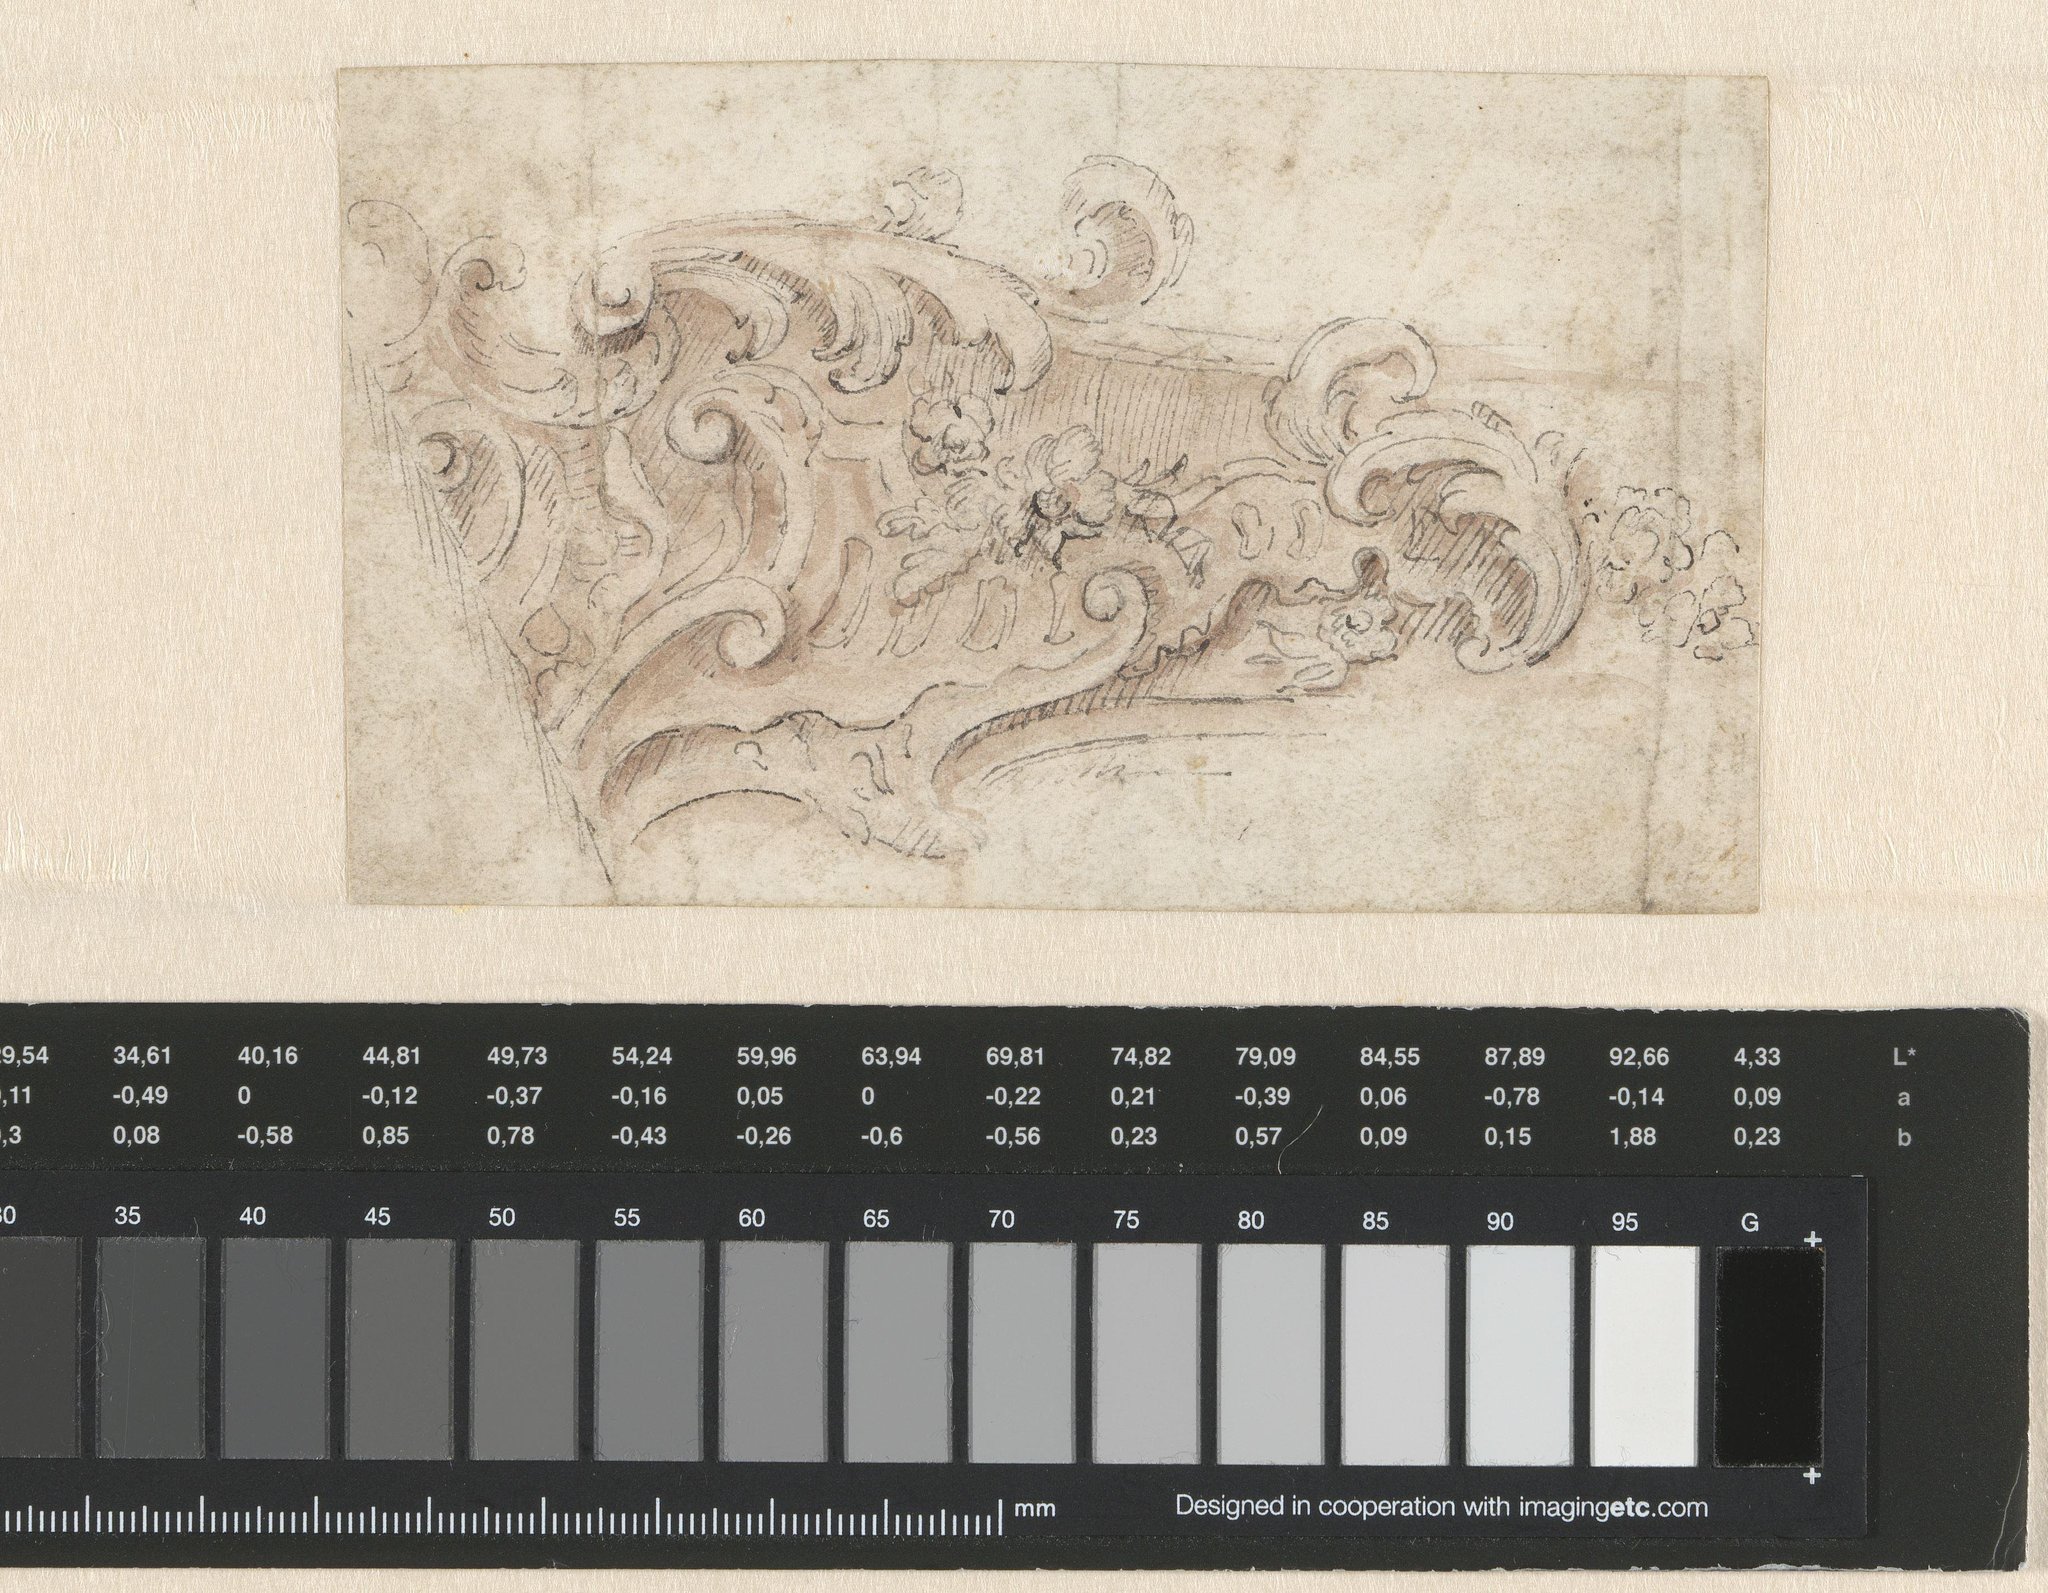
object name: drawing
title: Ontwerp voor een hoek van een lijst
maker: Anonymous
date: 1735-1750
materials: graphite, ink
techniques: brush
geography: france